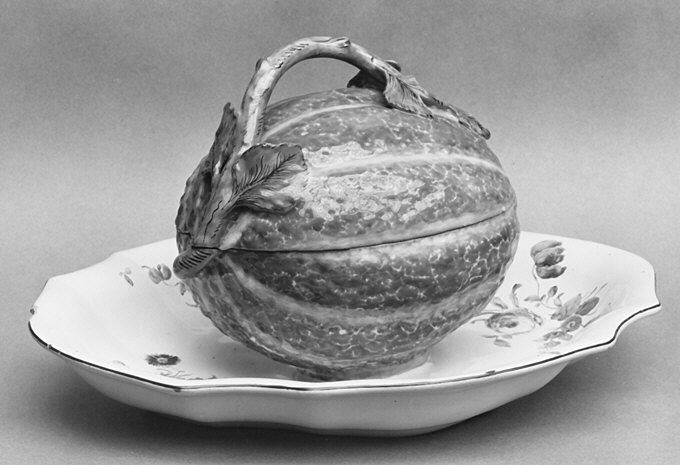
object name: tureen with cover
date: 1750-1770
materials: faience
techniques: glazing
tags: fruit